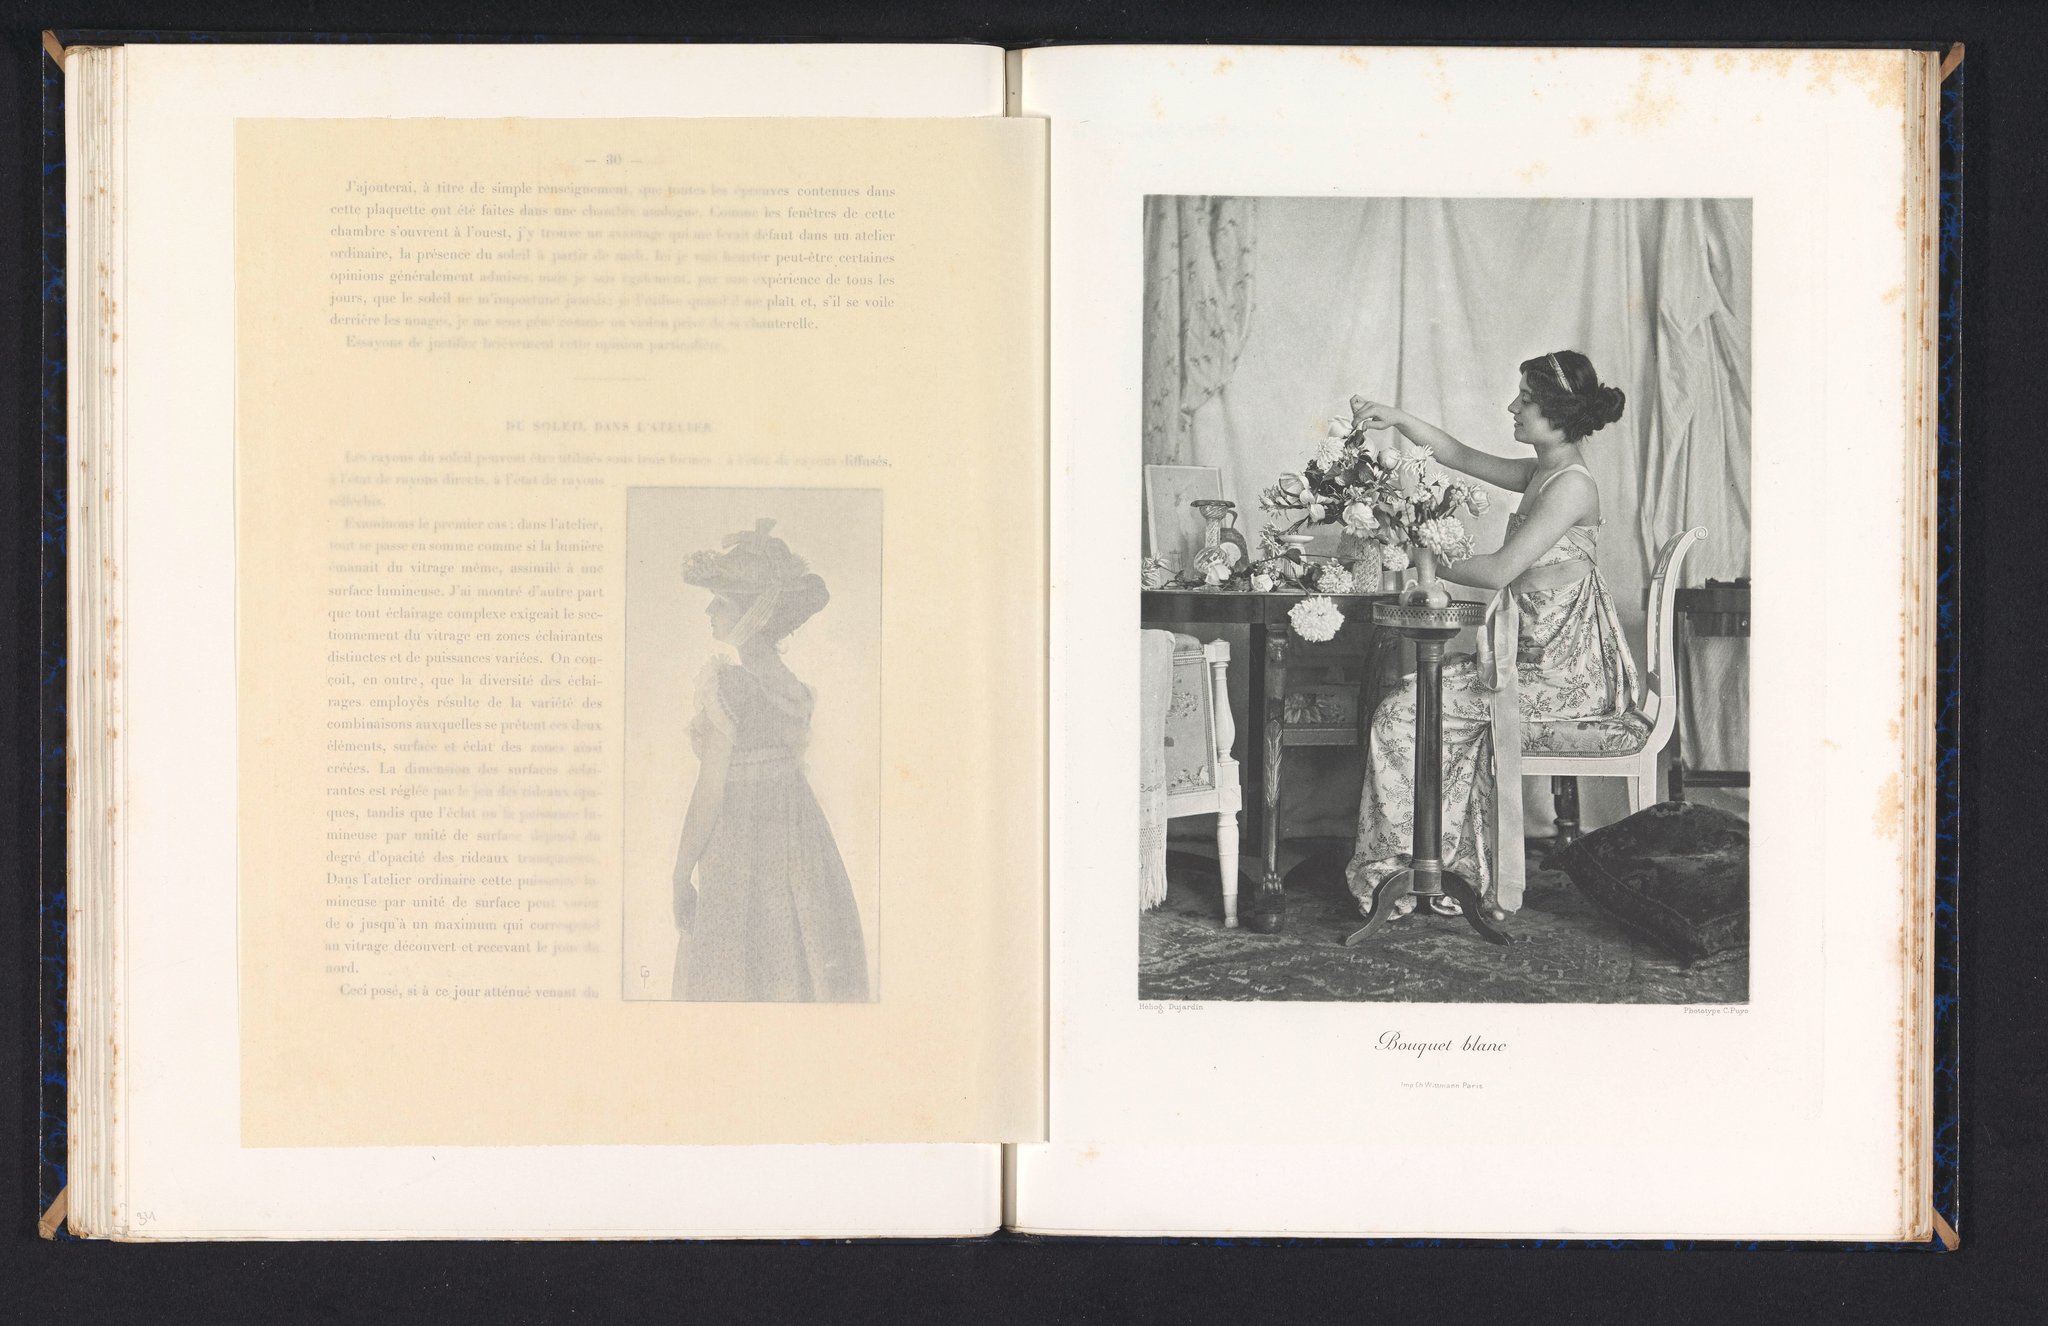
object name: page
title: Bloemschikkende vrouw in een interieur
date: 1886-1896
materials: paper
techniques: photoaquatint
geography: france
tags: adult woman, arranging flowers, interior ~ representation of a building